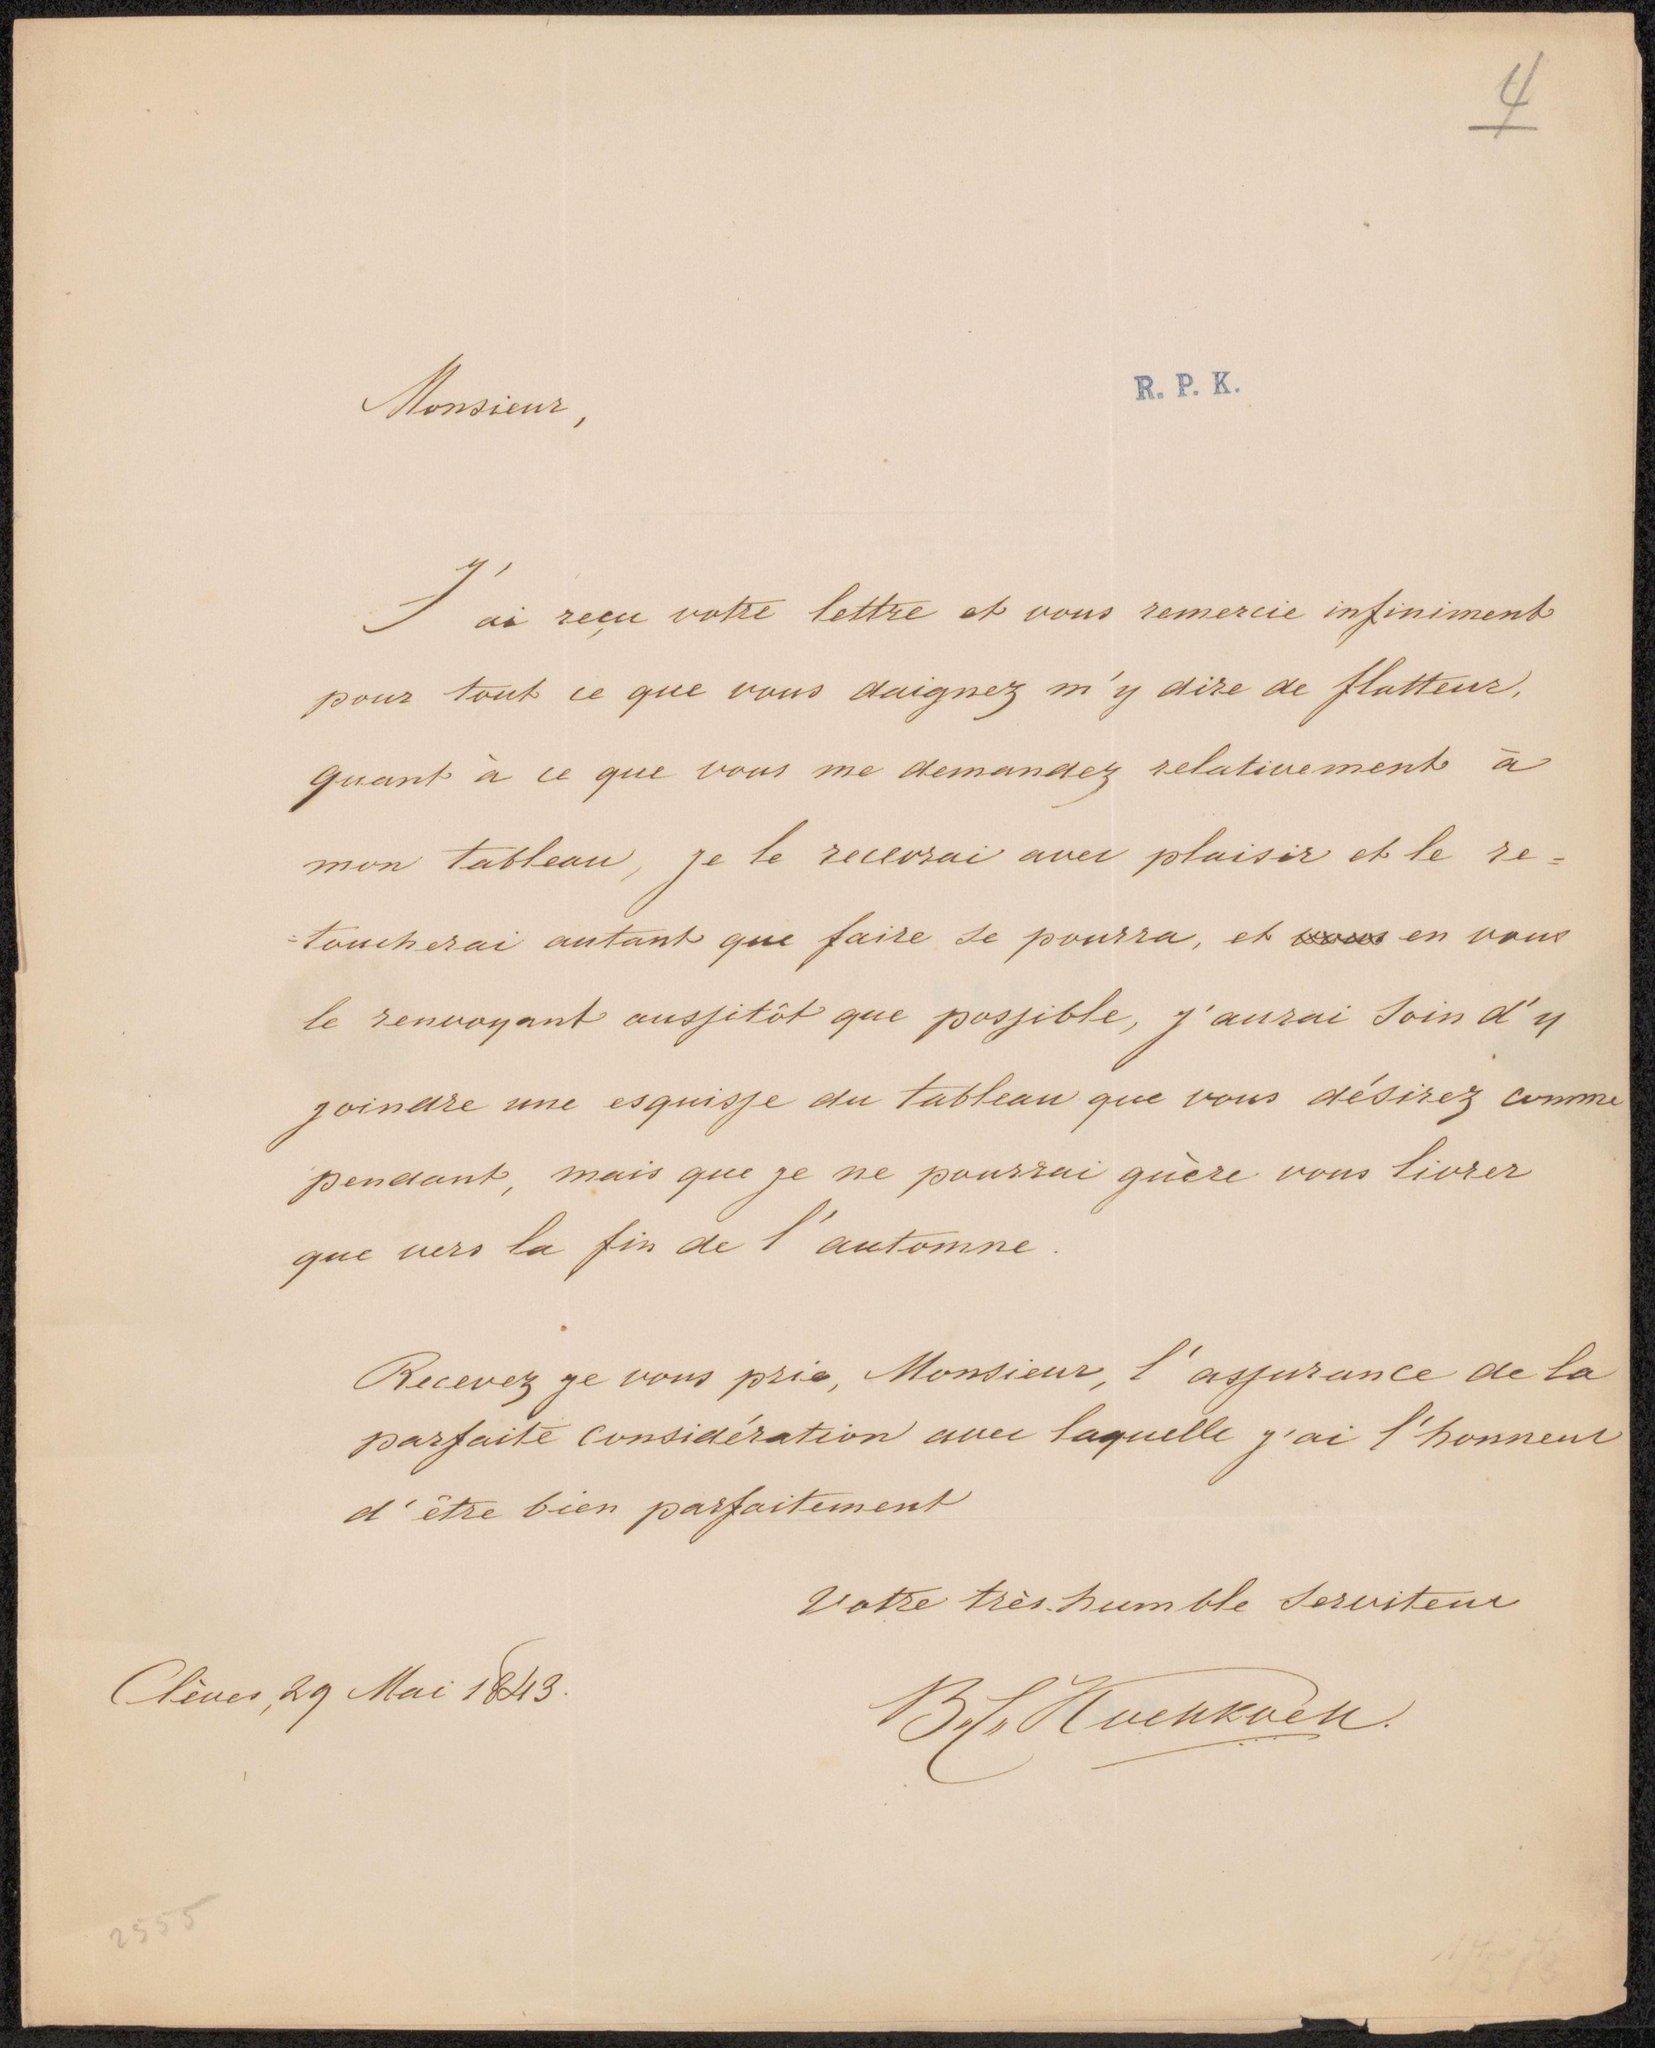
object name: letter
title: Brief aan R. Engels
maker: barend cornelis koekkoek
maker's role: draughtsman, painter, print maker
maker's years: 1803-1862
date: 1843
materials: ink, paper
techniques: pen, writing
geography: cleves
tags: painting (including book-illumination, miniature-painting), cologne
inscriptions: seal, collector's mark: Lugt 2233, collector's mark